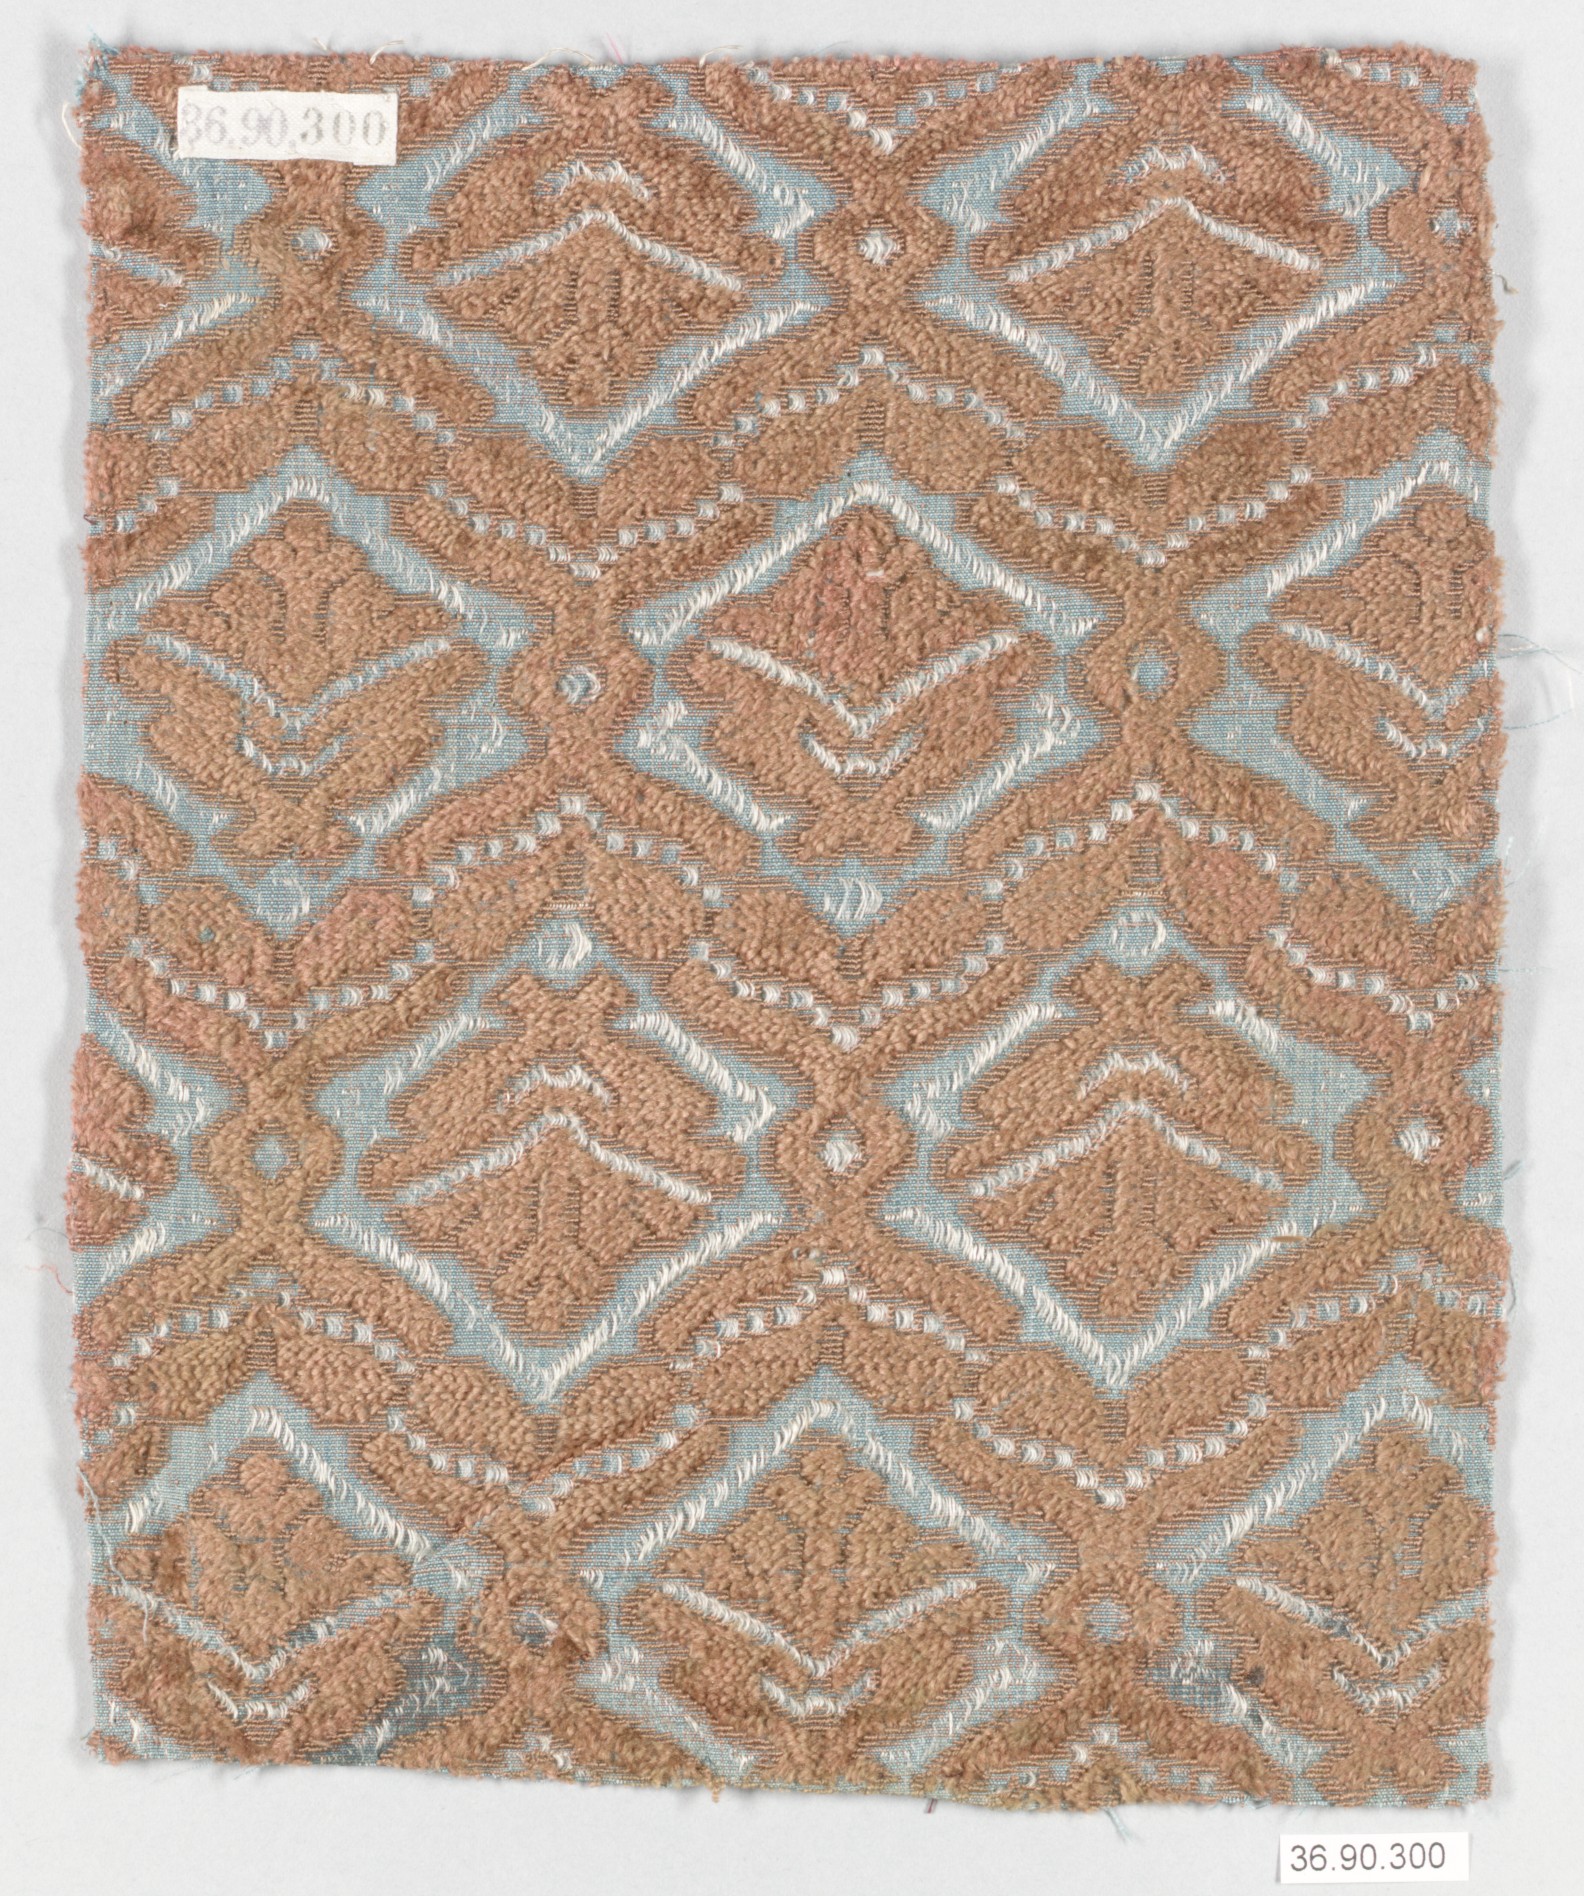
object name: piece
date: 1501-1700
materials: silk